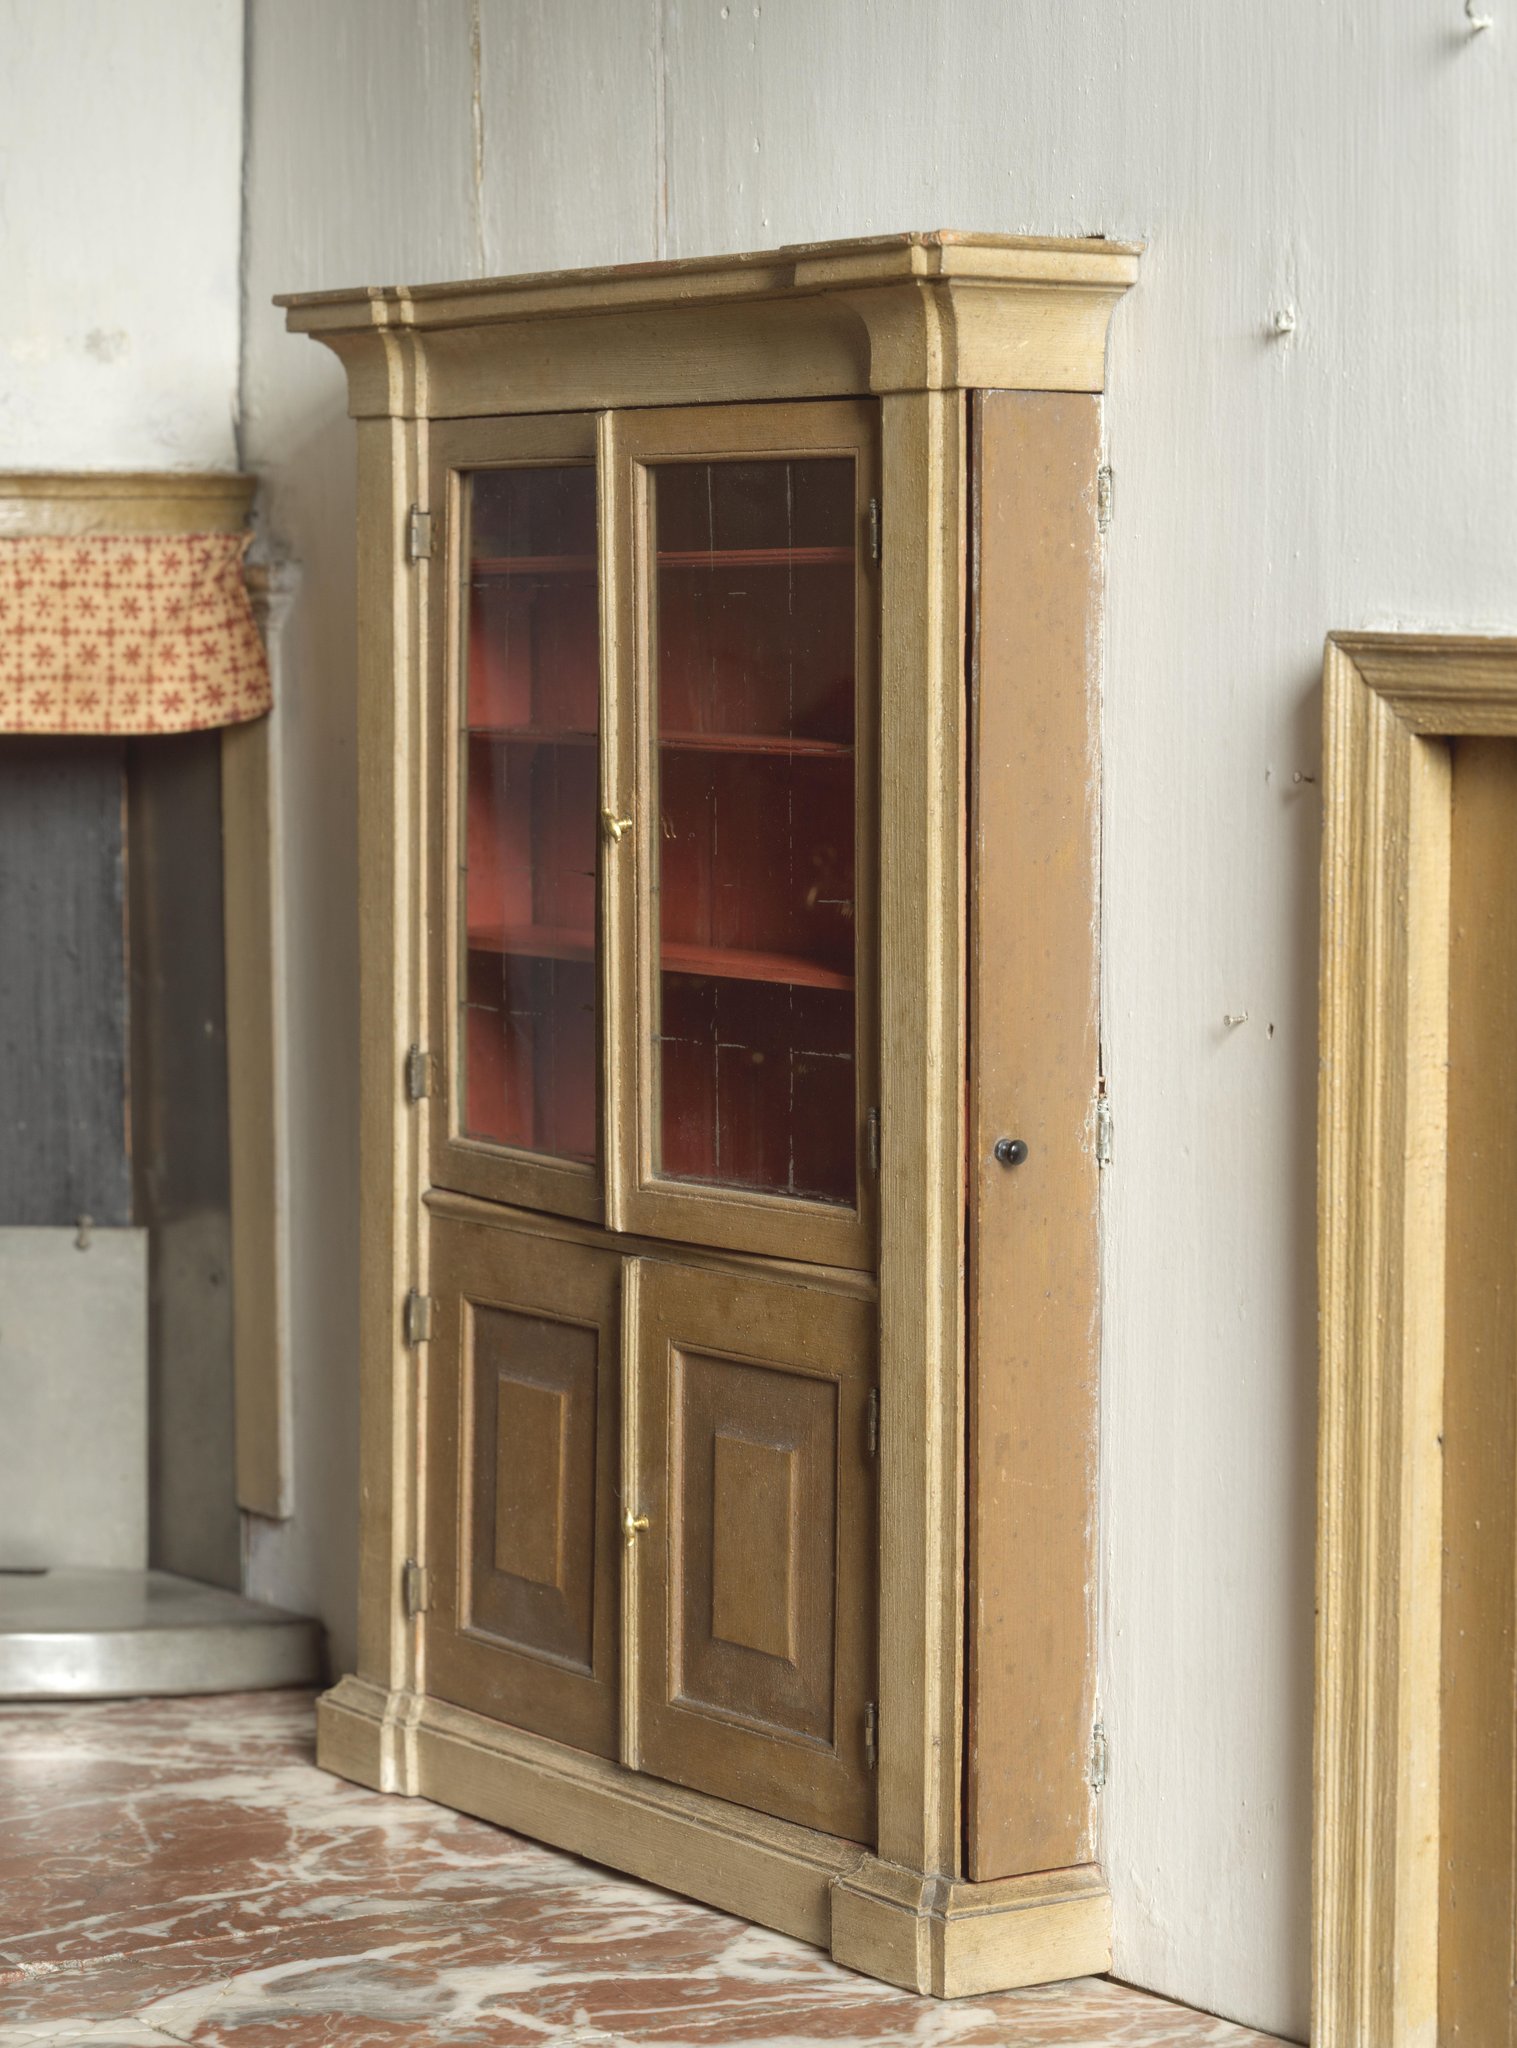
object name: miniature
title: Tinkast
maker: Anonymous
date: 1690-1710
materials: brass, wood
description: Wandkast, vervaardigd van in drie tinten mosgroen geschilderd hout, bestemd voor 'tin'; bovenkast met twee glas deuren, onderkast met dichte deuren, voorzien van opgelegde panelen en rond profiel. De deuren worden geflankeerd door vlakke pilasters, een naar voren uitstekende kroonlijst en een plint, die verkropt zijn t.h.v. de pilasters. Achter de rechter pilaster is een smalle hoge bezemkast aangebracht, die aan de zijwand geopend wordt. De deuren draaien op fijn gedetailleerde scharnieren.